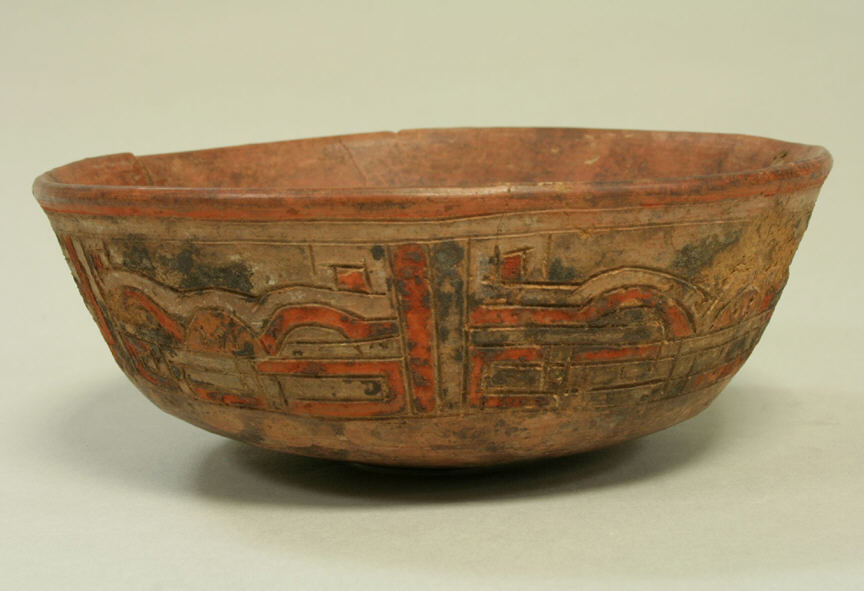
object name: bowl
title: Incised Painted Bowl with Feline Faces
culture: paracas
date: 500-101 BCE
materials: ceramic, pigment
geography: peru